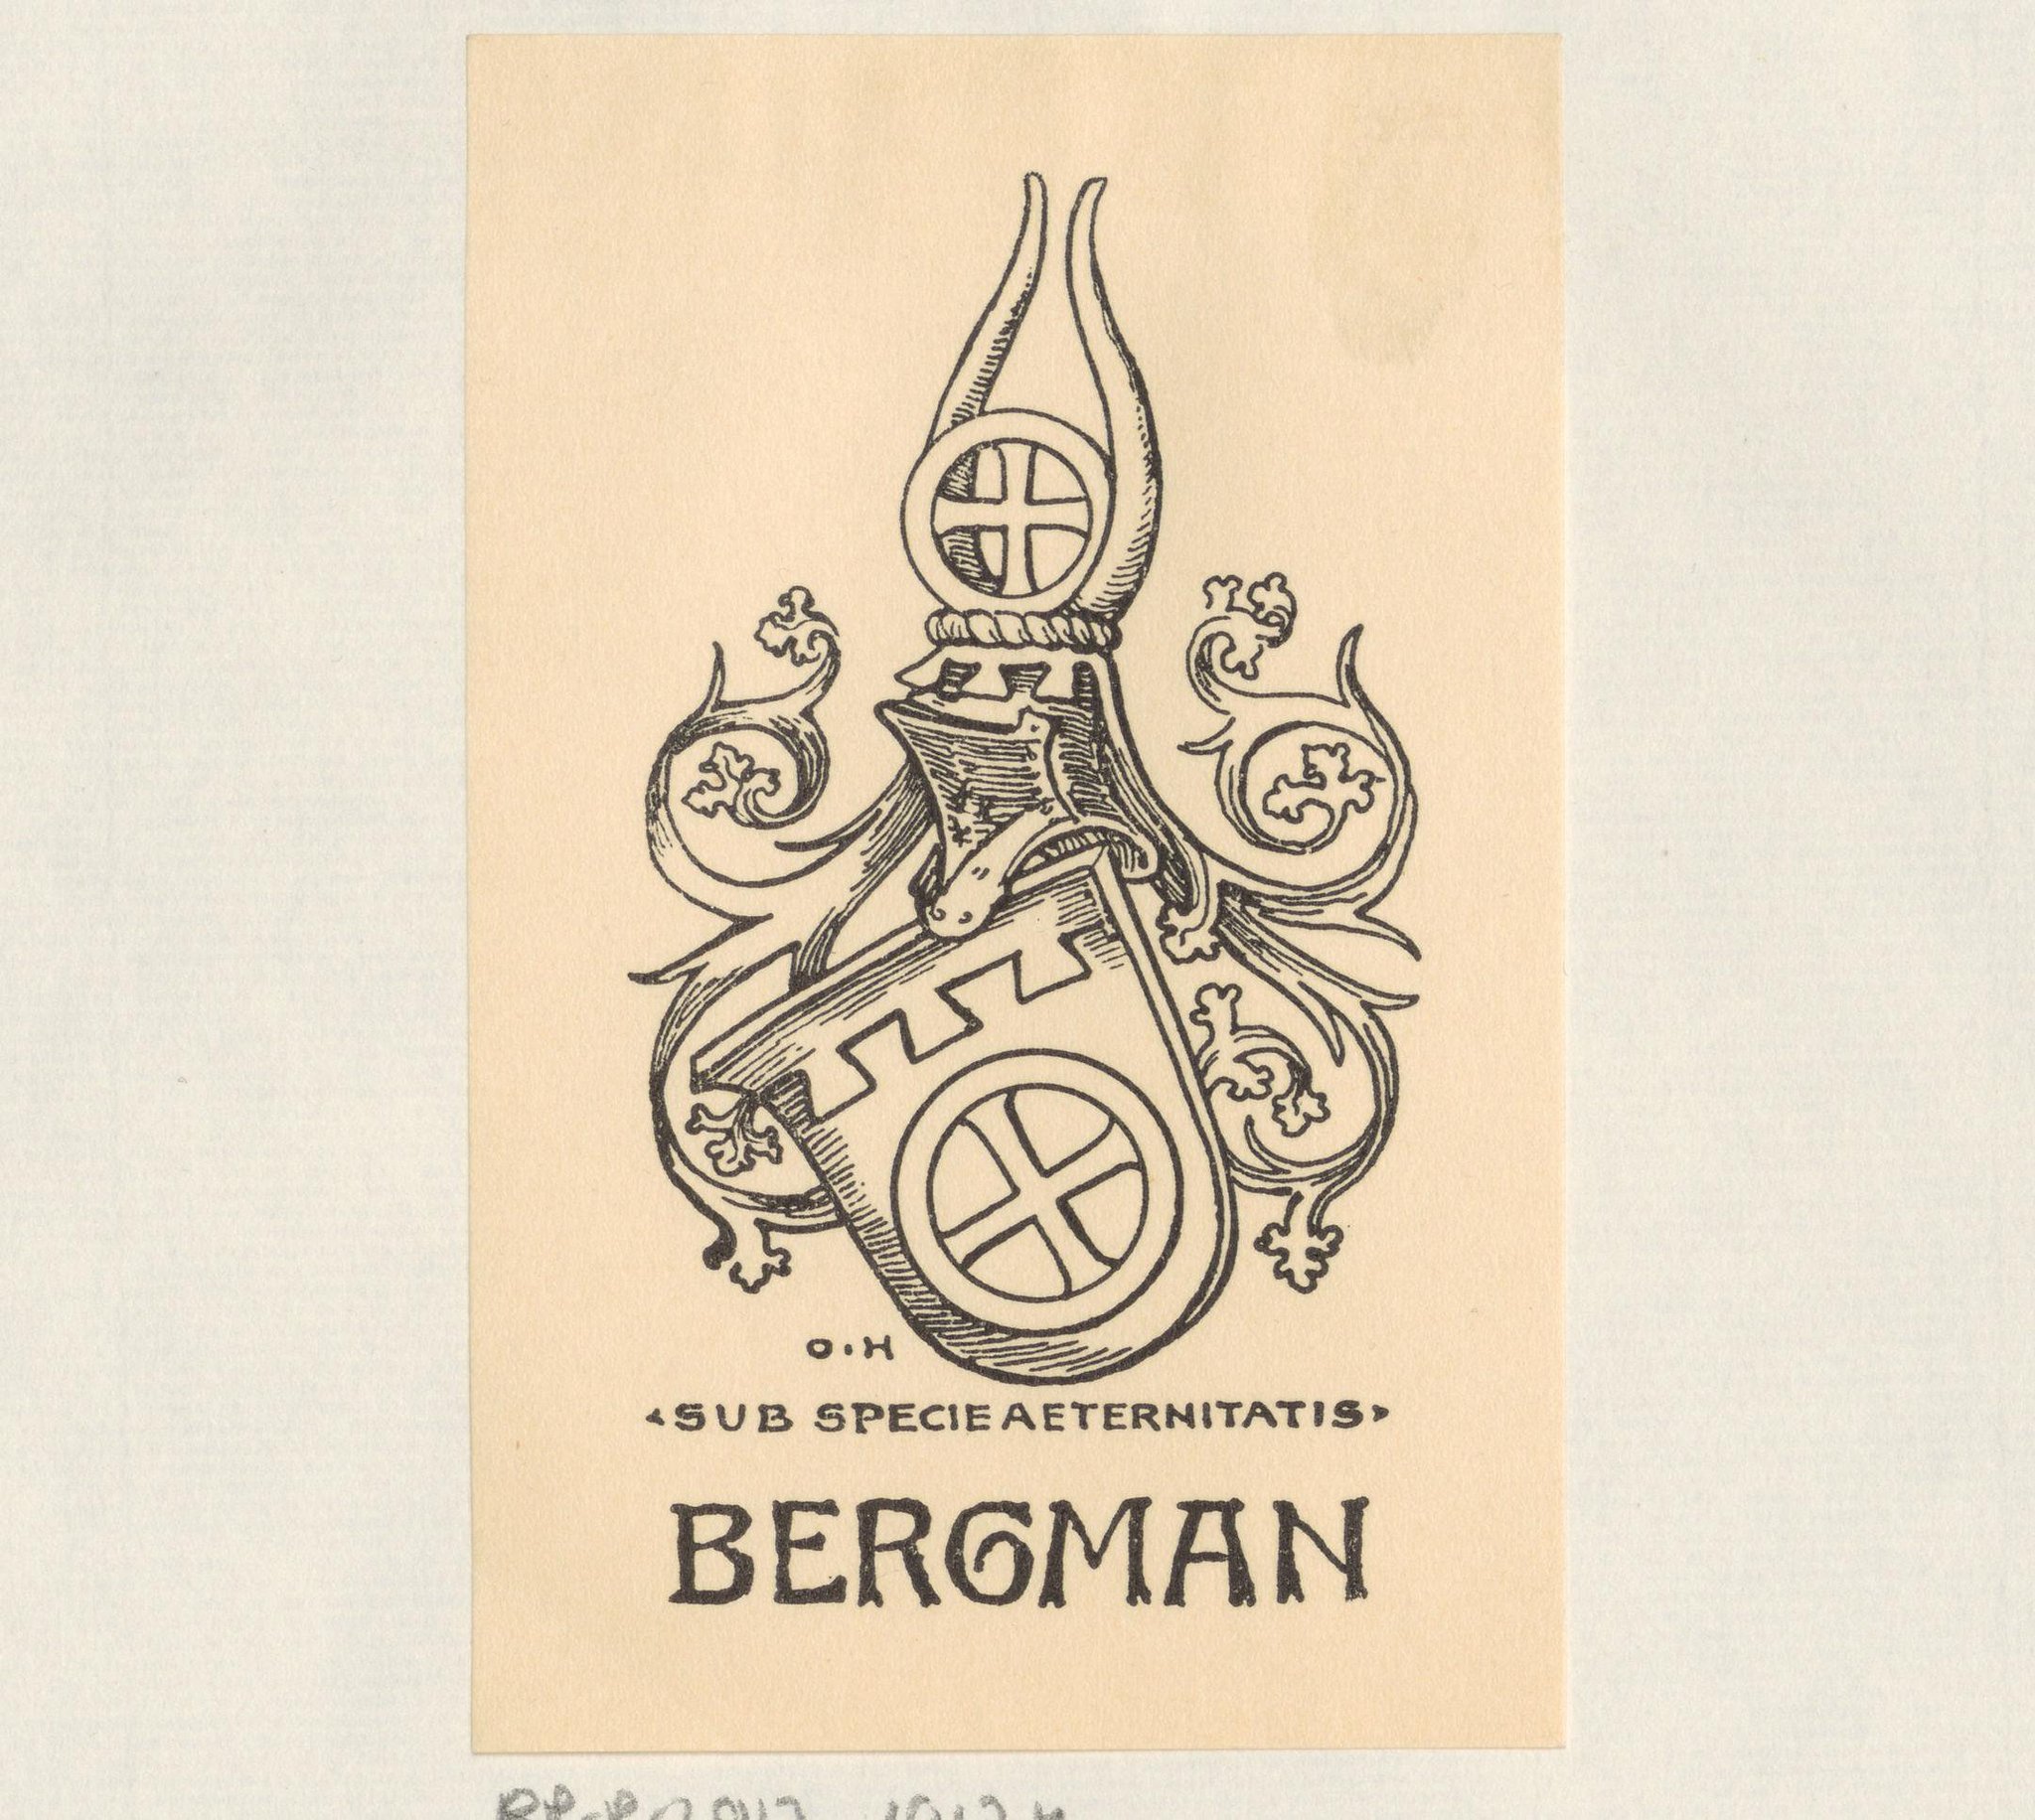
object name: bookplate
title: Sub specie aeternitatis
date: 1940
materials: paper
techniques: printing block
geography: germany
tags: armorial bearing, heraldry